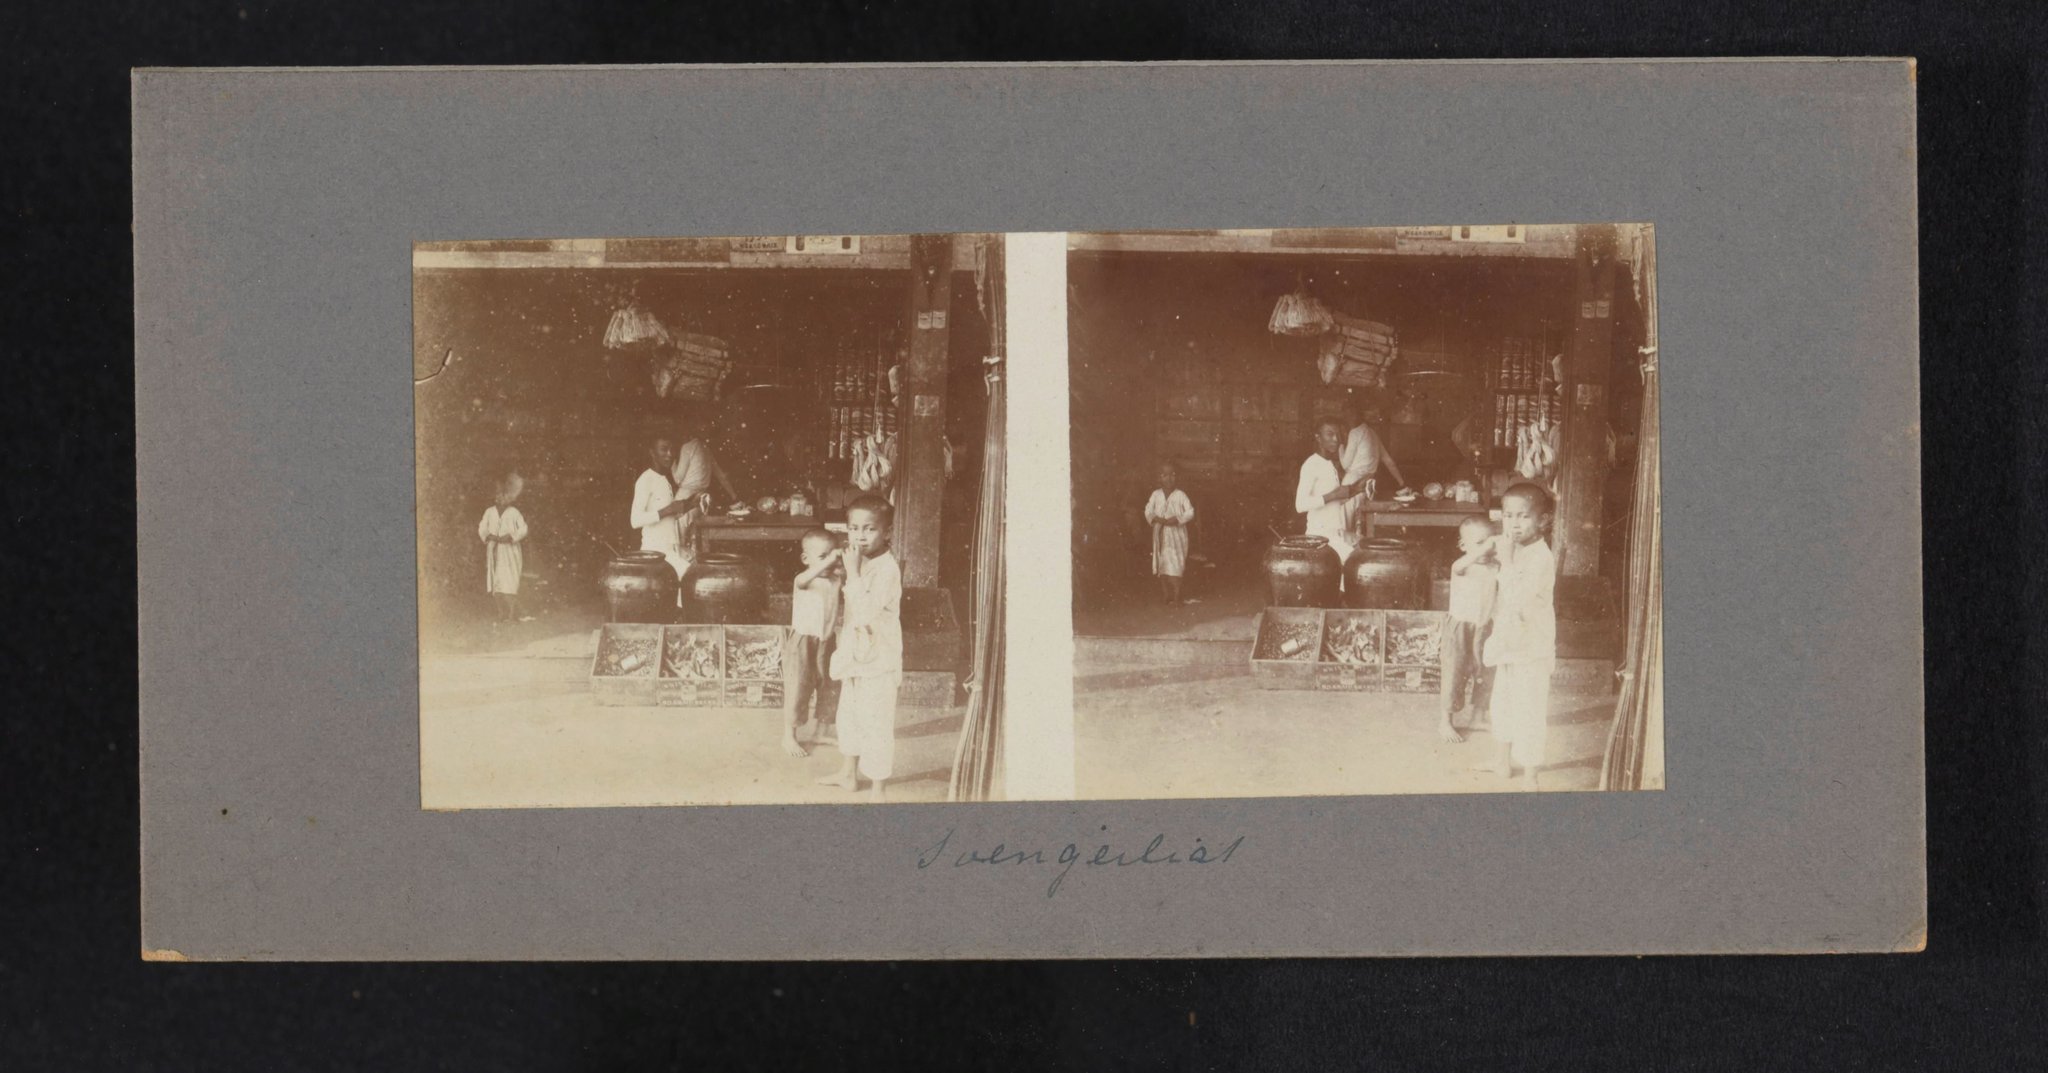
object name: stereograph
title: Kruidenier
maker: robert julius boers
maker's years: 1867-1932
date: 1900-1922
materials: cardboard, photographic support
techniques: gelatin silver print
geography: bangka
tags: robert julius boers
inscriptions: inscription: ‘Soengeiliat’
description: Kruidenier te Soengeiliat op Banka. Onderdeel van een groep stereofoto's van Robert Julius Boers, chef van het staatsbedrijf de Banka-tinwinning op Banka, uit de periode ca. 1900-1922.